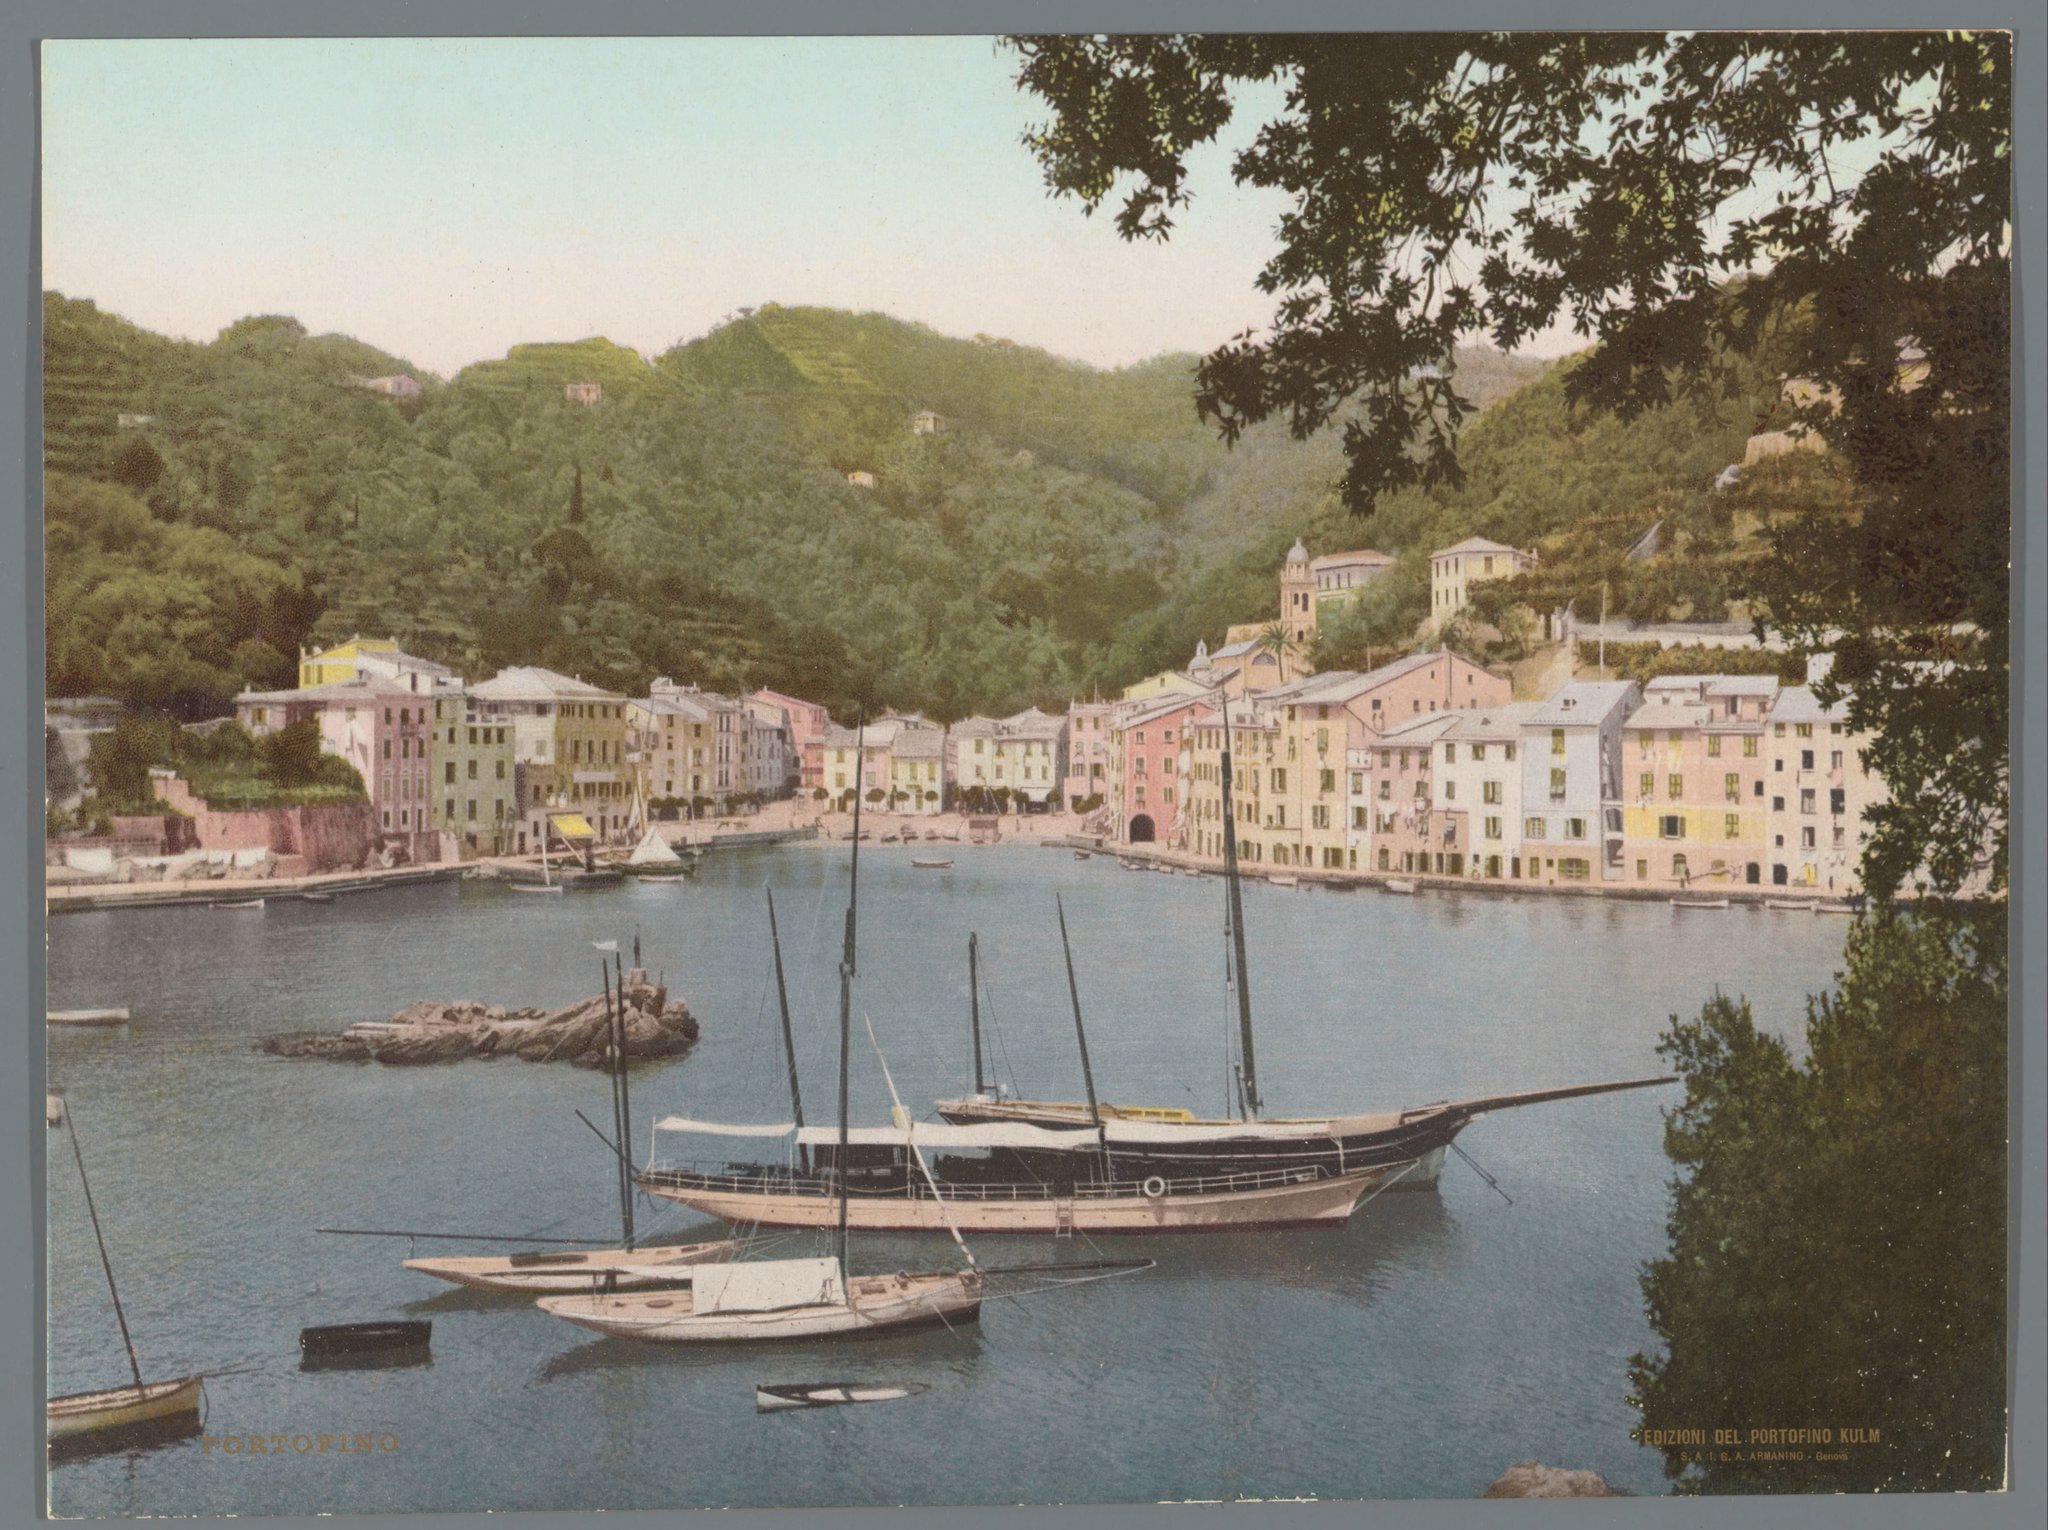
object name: photomechanical print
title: Portofino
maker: Anonymous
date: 1880-1917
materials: paper, photographic process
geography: portofino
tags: gulf, bay, city-view in general; 'veduta', traffic on the water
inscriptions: inscription: ‘EDIZIONI DEL PORTOFINO KULM/ S.A.I.G.A. ARMANINO - Genova’